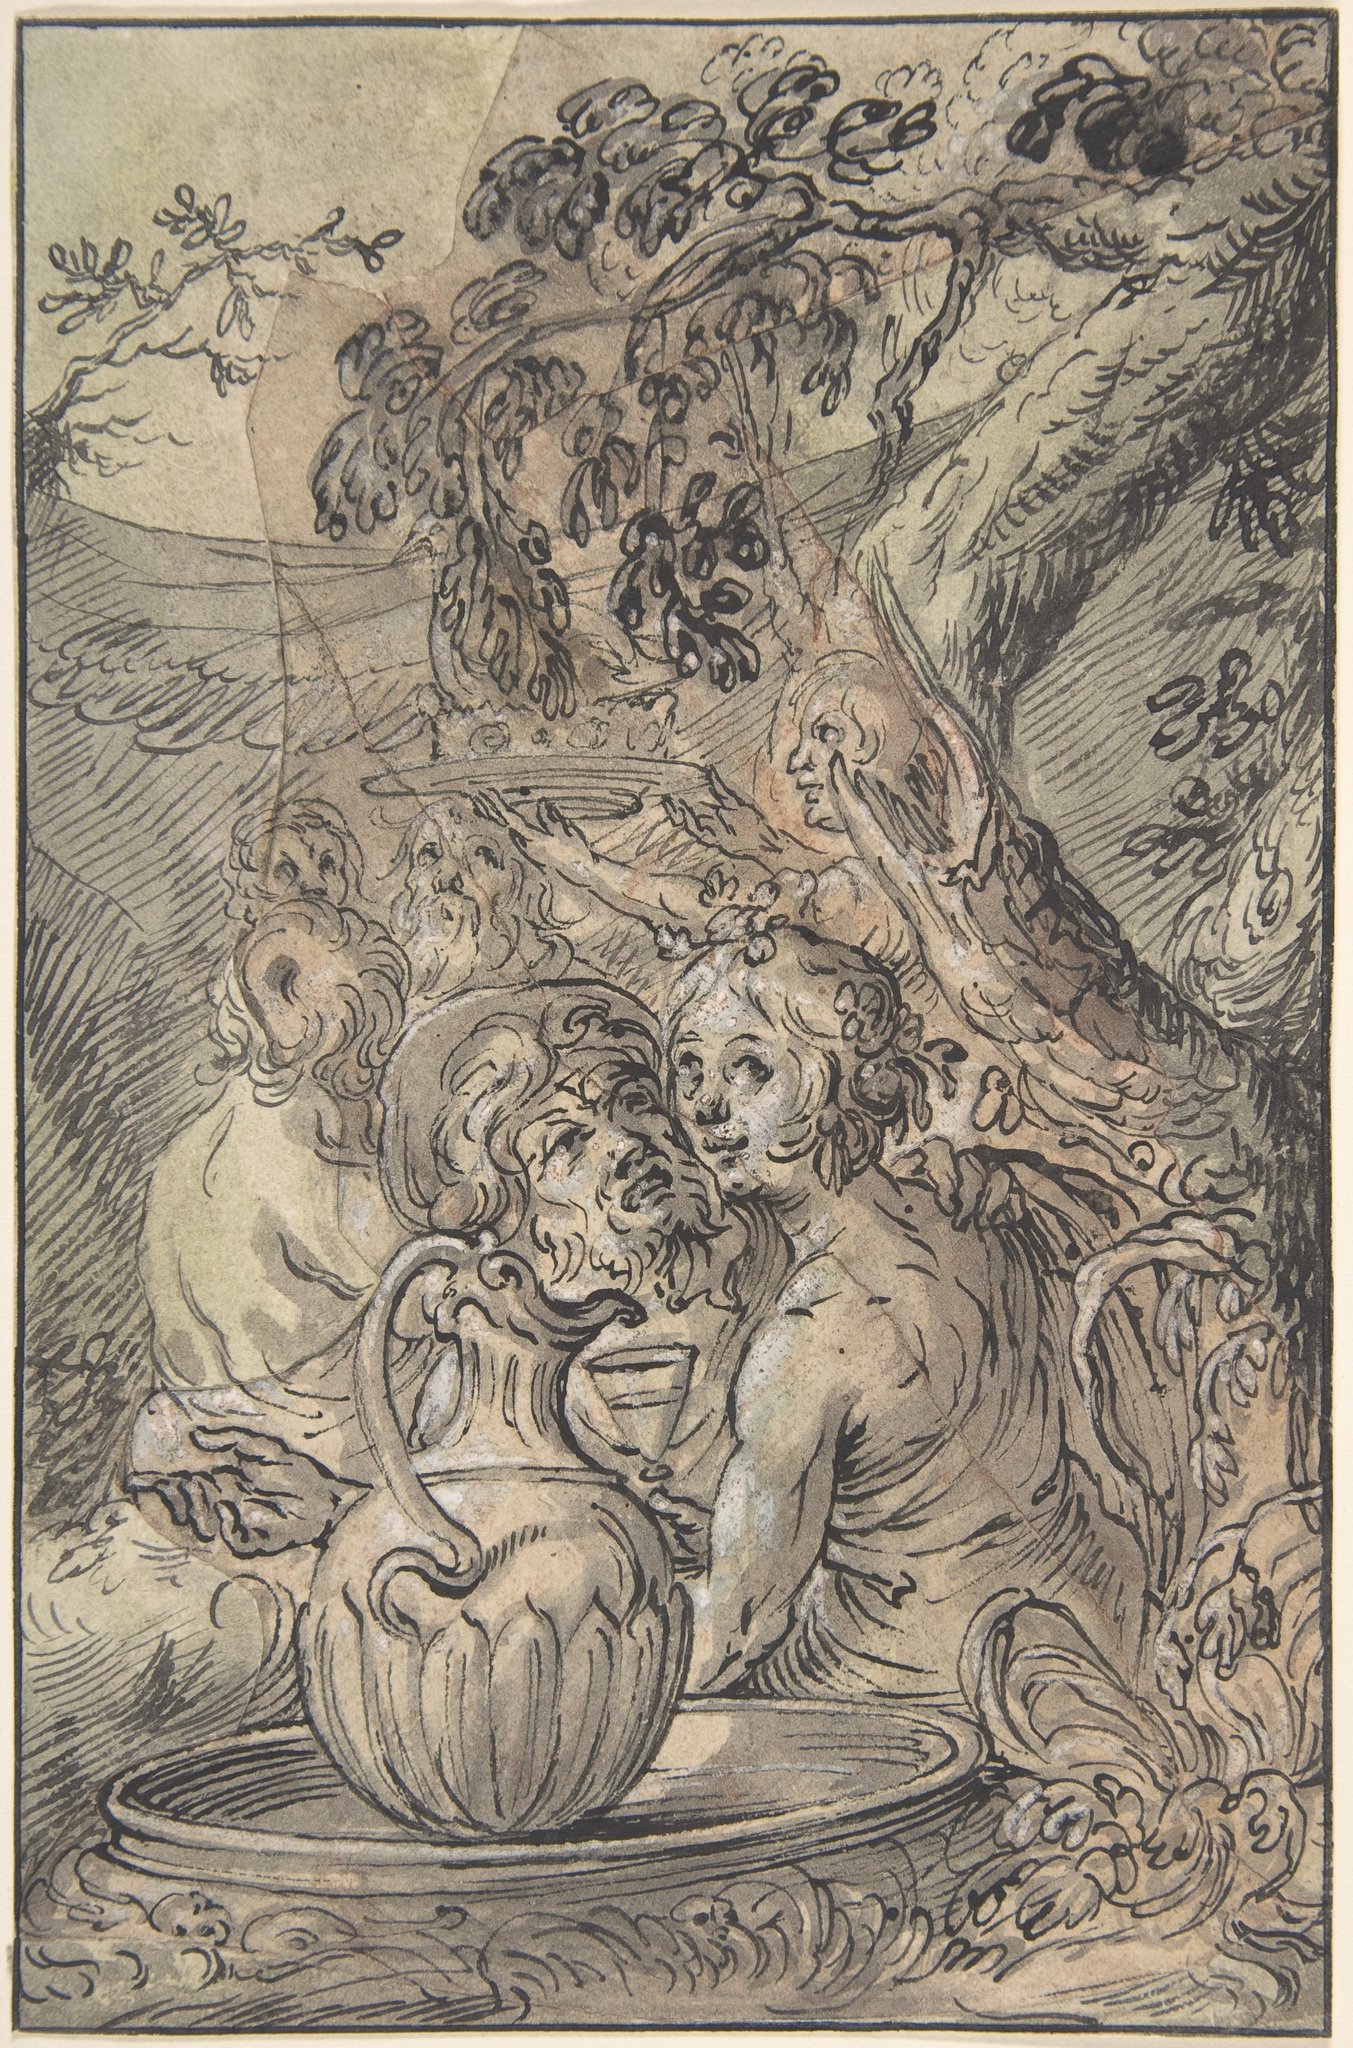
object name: drawing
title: Temptation of St Anthony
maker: anonymous, netherlandish, 16th century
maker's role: artist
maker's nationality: netherlandish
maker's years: 1500-1600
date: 1501-1600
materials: ink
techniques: brush, drawing, heightening, pen, wash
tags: men,women,trees,saints